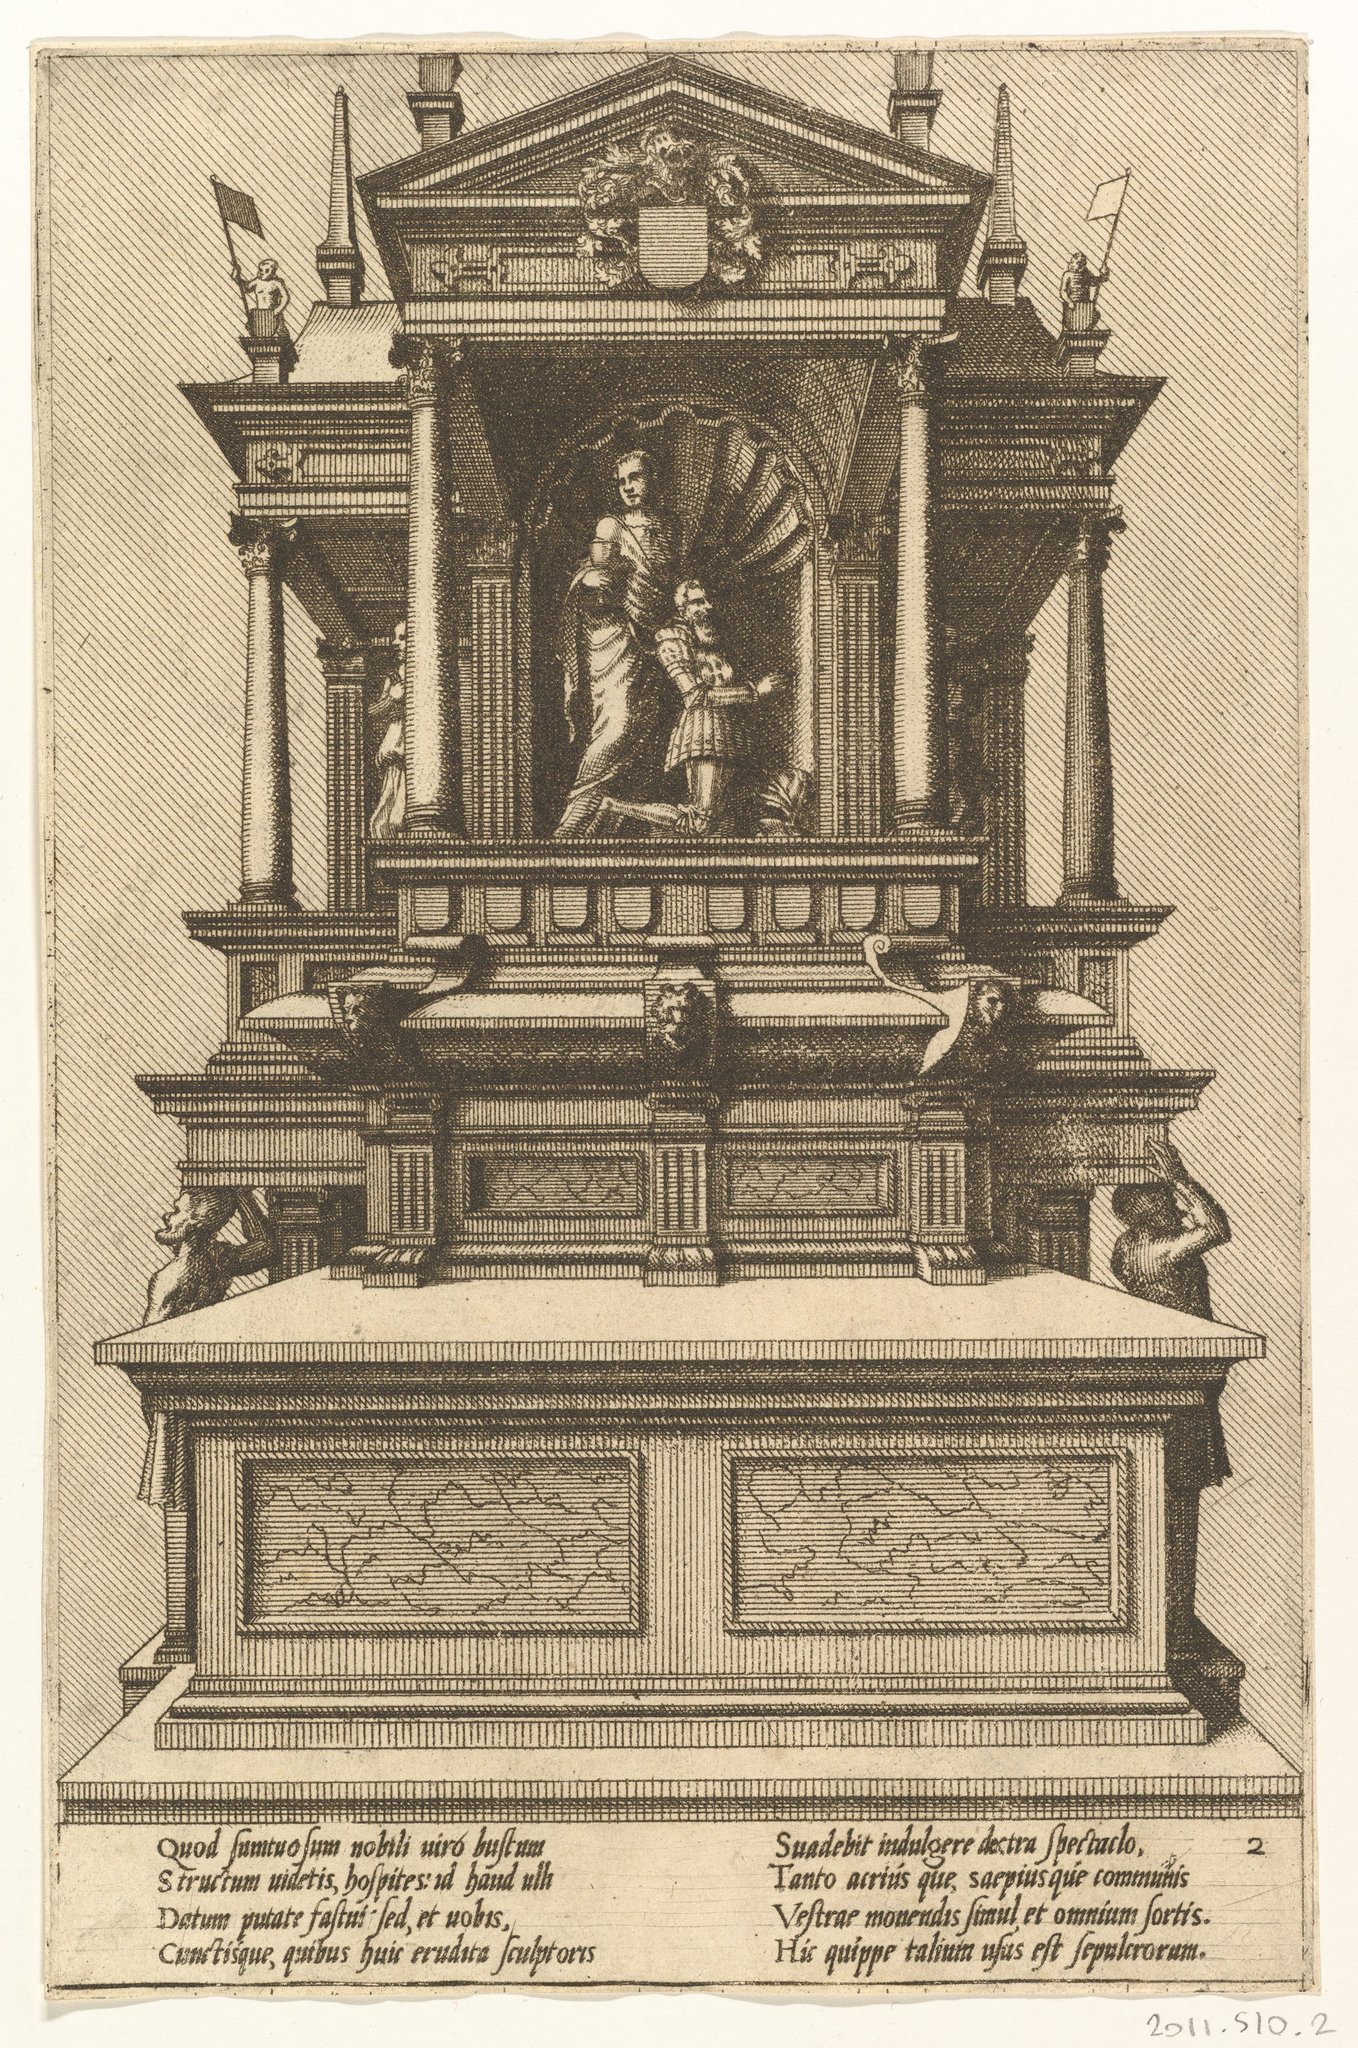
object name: collection ornament architecture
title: Cœnotaphiorum (2)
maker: hans vredeman de vries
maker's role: artist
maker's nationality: netherlandish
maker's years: 1527-1606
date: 1563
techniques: etching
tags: architecture,altars,men,saints